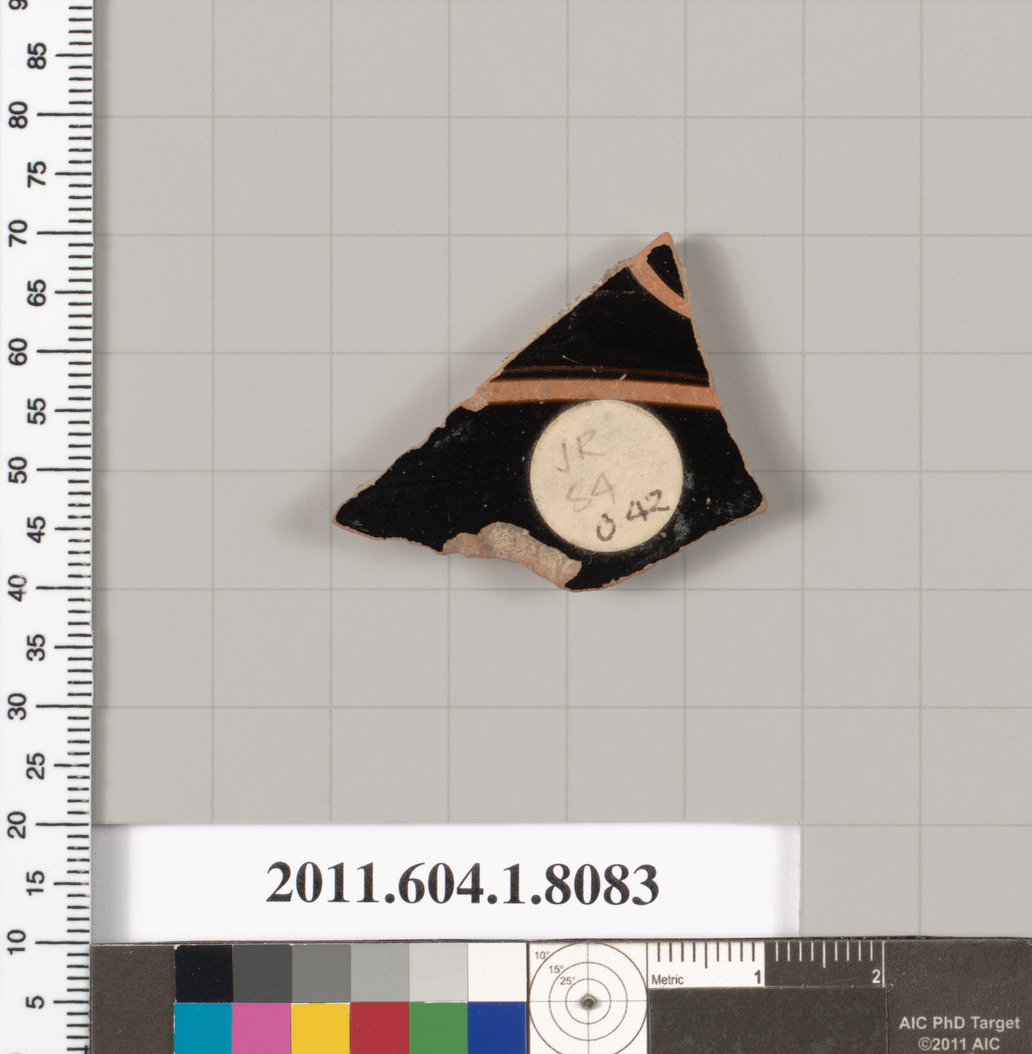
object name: kylix fragment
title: Terracotta fragment of a kylix (drinking cup)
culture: greek, attic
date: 510-500 BCE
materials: terracotta